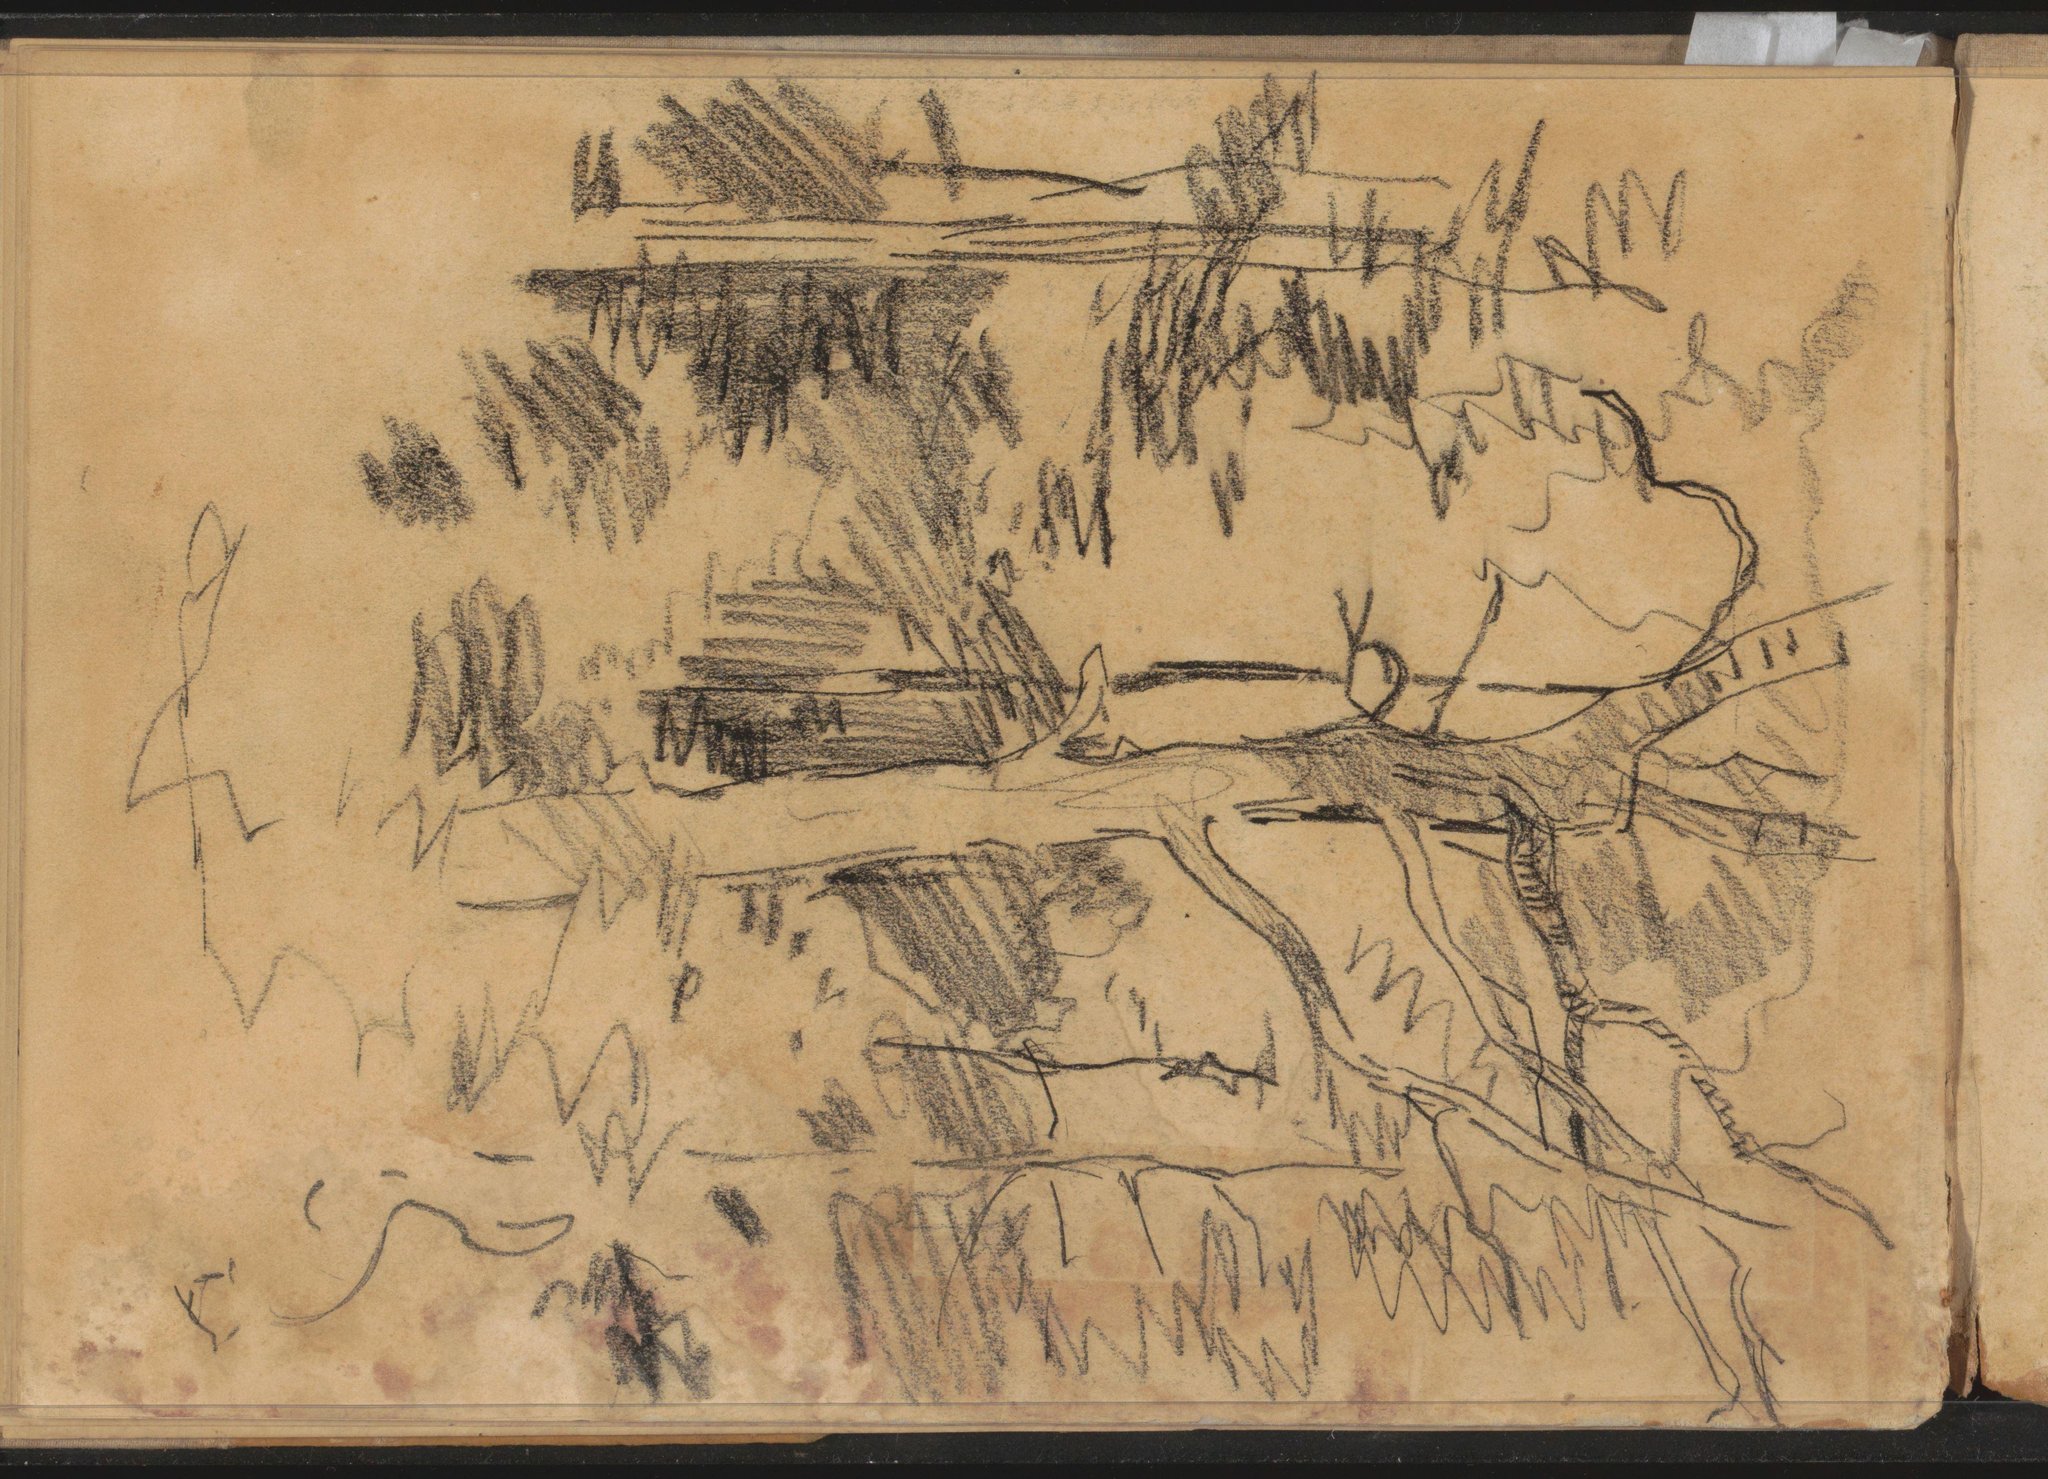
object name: sketchbook leaf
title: Bomen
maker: willem bastiaan tholen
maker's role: draughtsman, painter, print maker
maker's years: 1860-1931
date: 1885-1931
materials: chalk, paper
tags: trees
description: Blad 28 verso uit een schetsboek met 28 bladen.